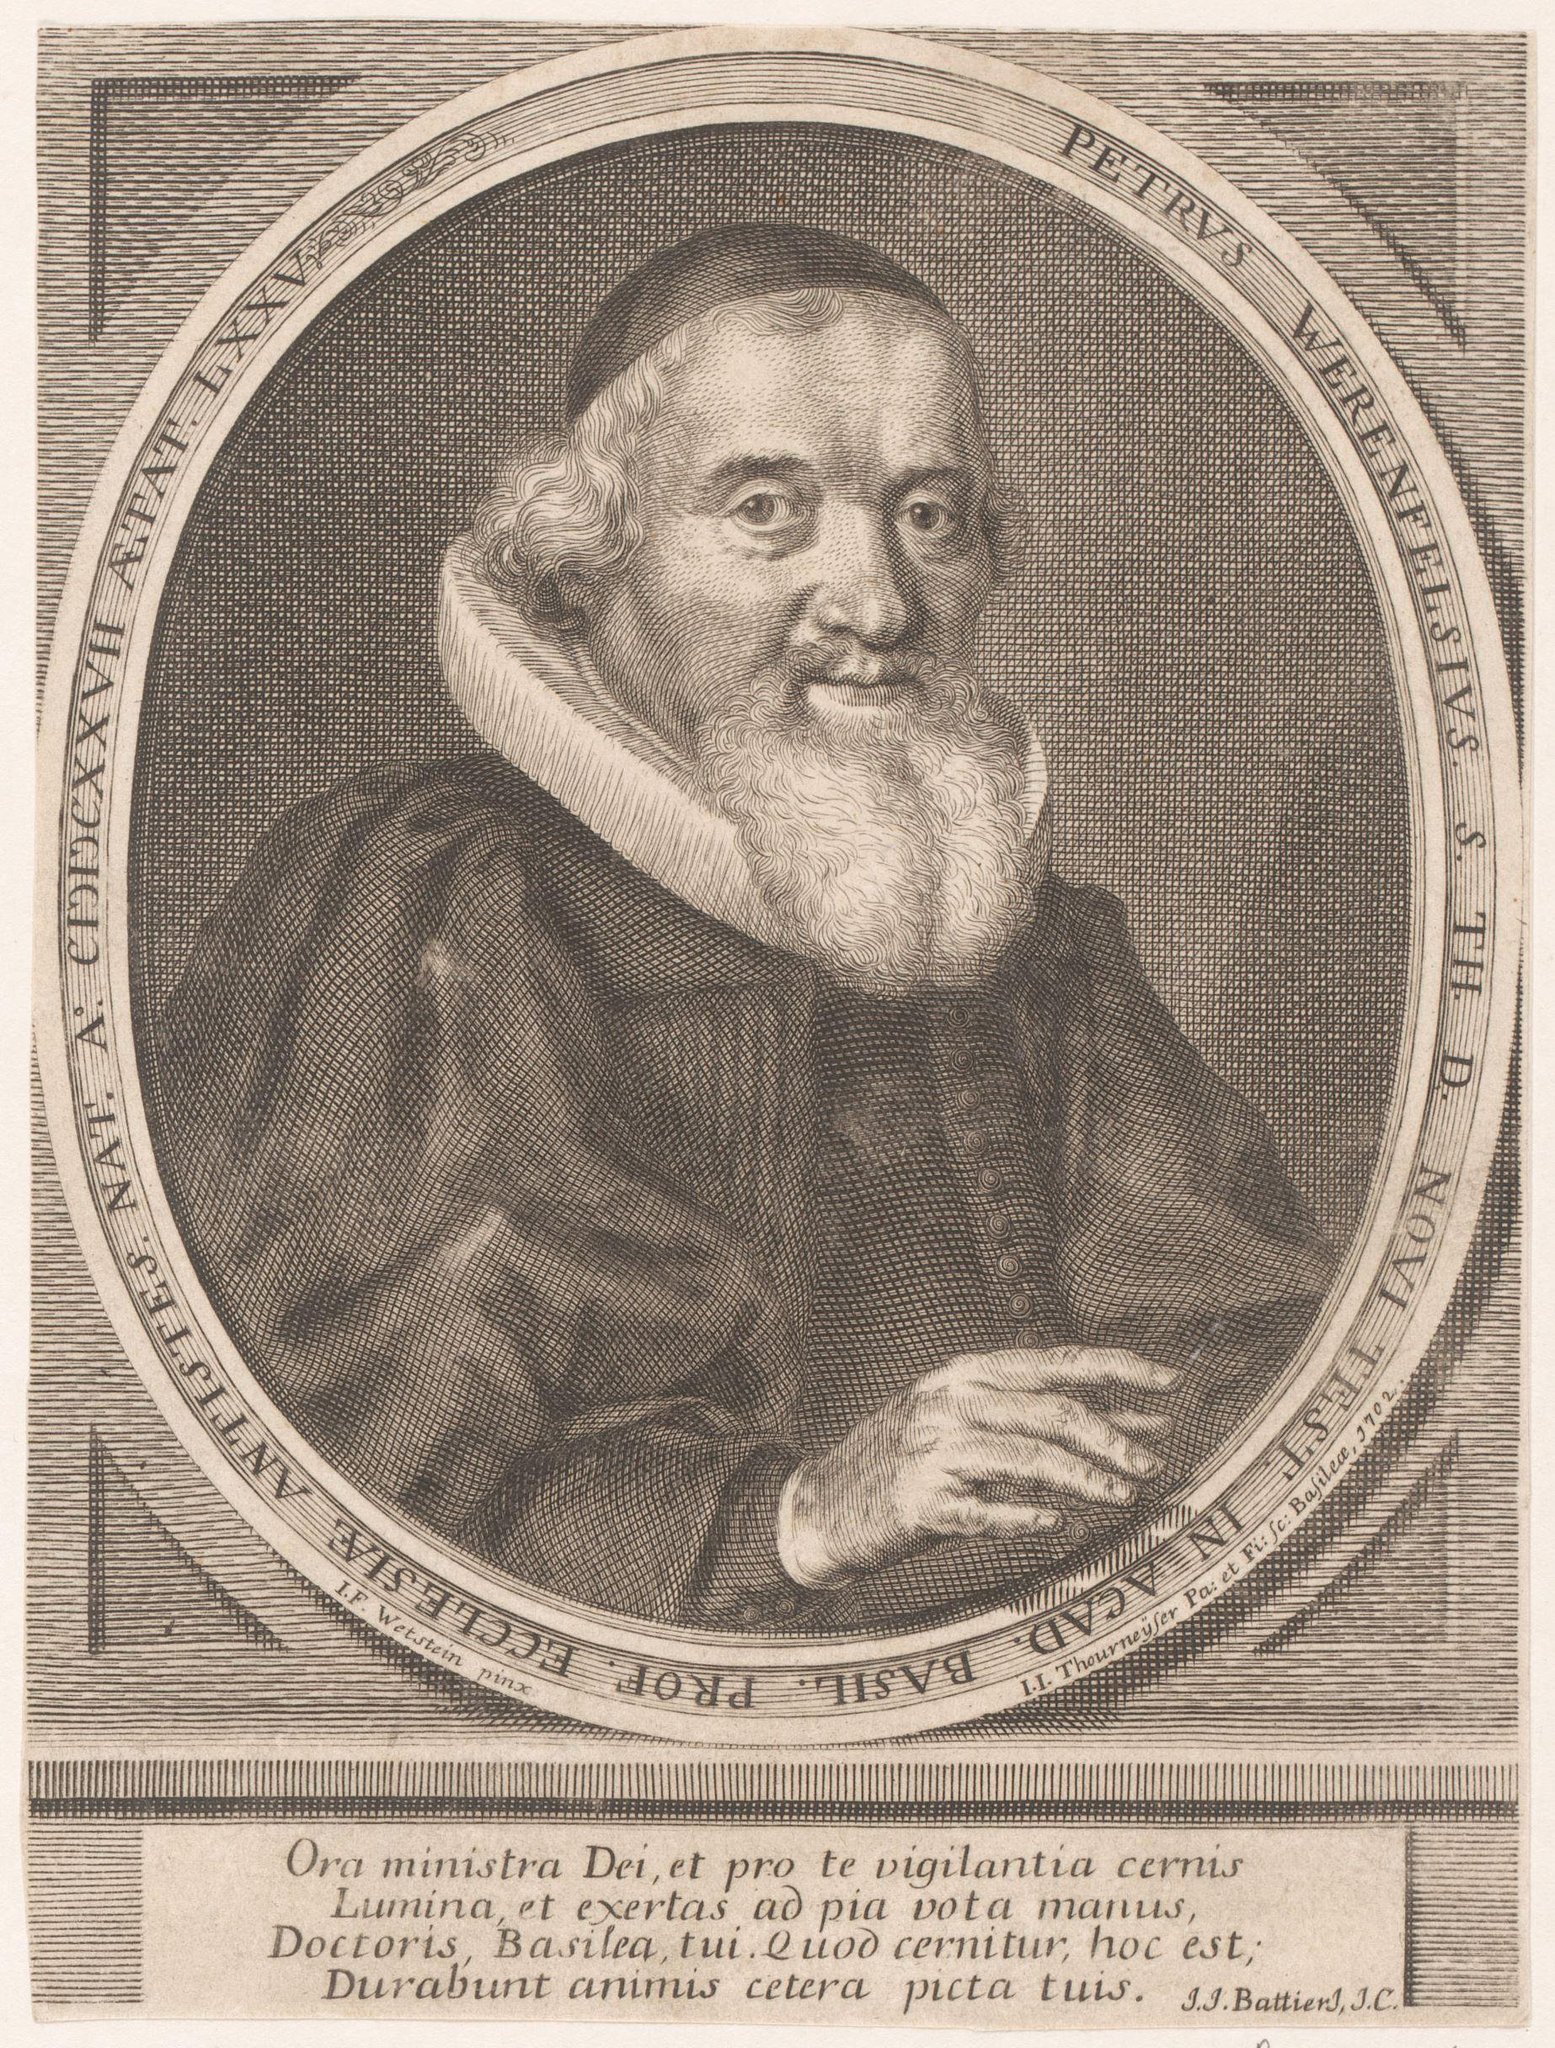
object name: print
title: Portret van Peter Werenfels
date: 1702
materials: paper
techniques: engraving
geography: basel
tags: historical persons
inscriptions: collector's mark: Lugt 2228